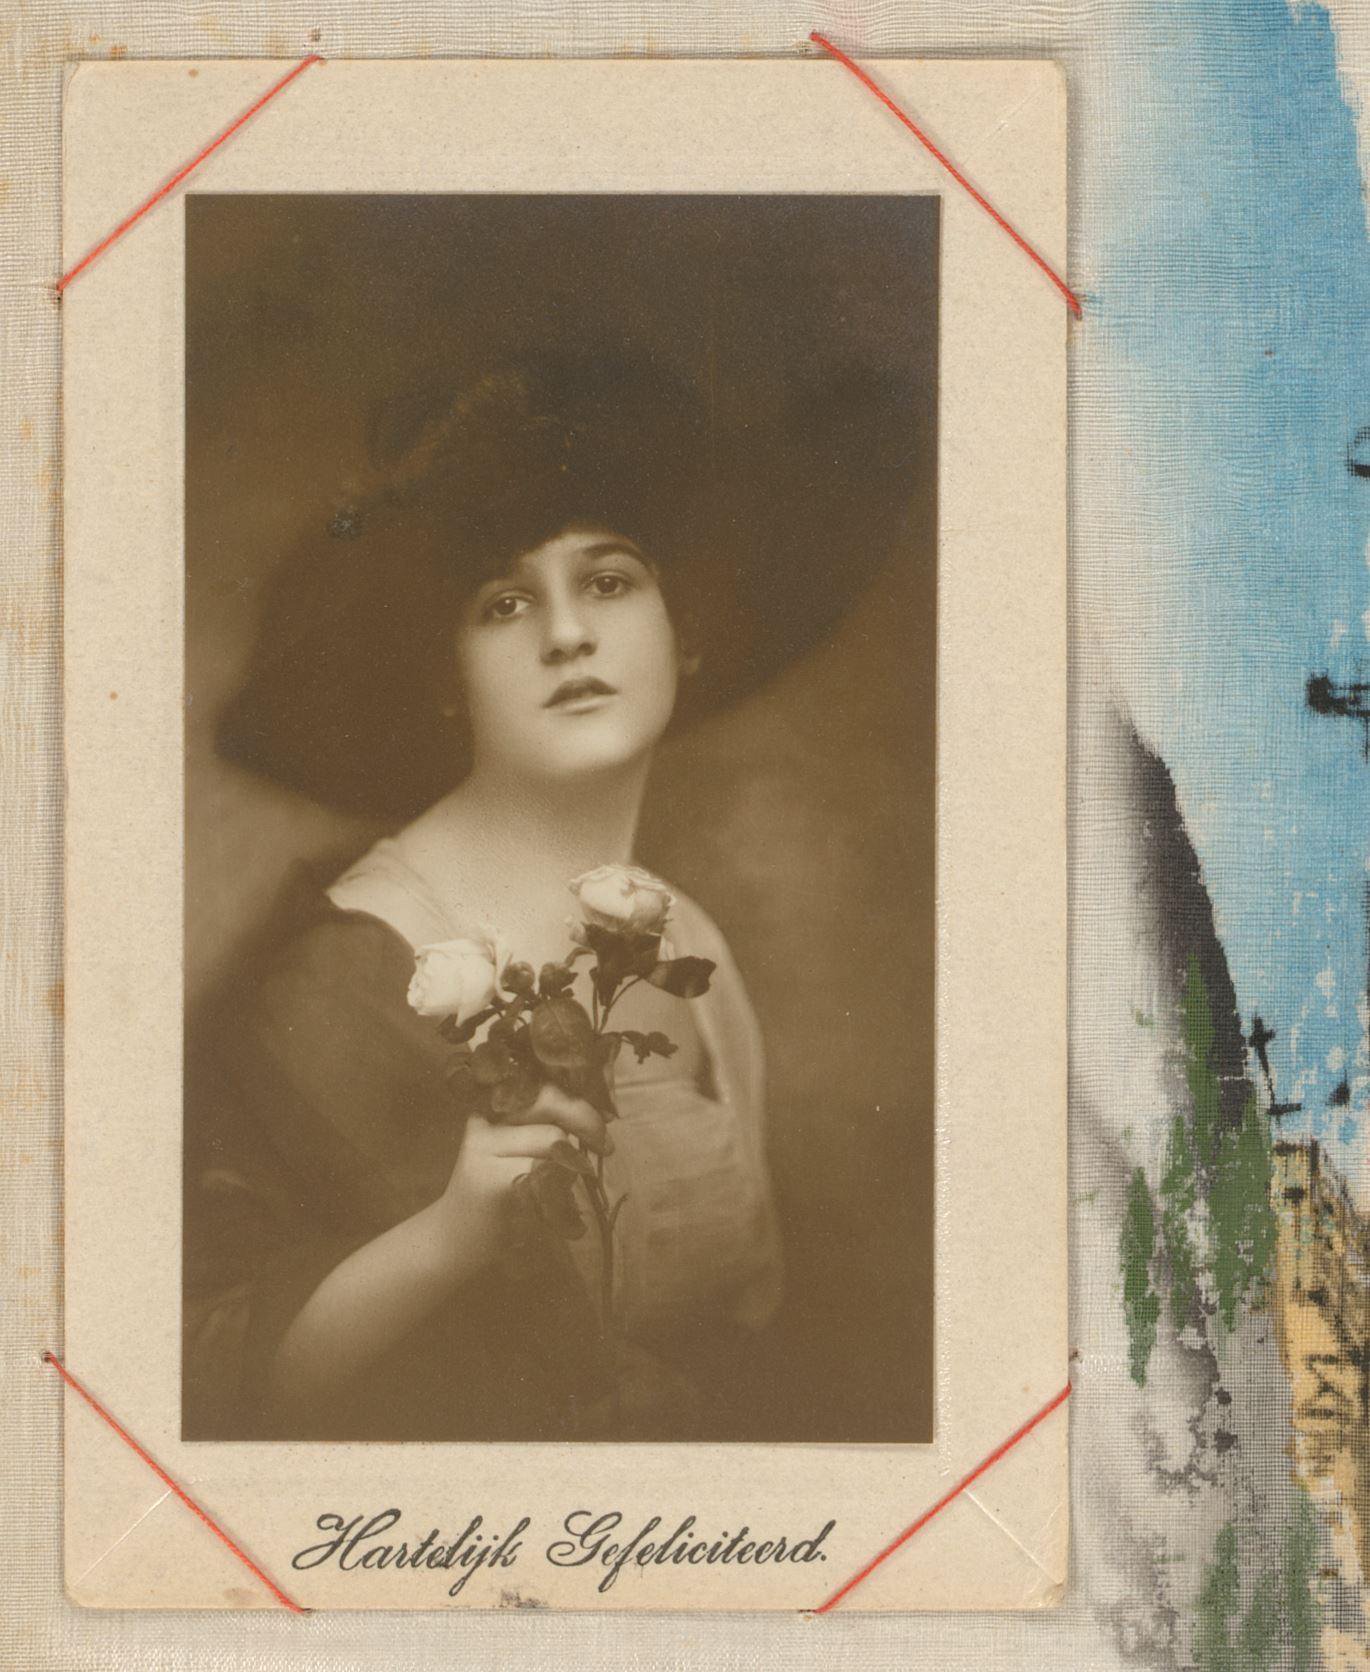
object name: photograph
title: Hartelijk Gefeliciteerd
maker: Anonymous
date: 1880-1920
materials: paint, photographic support, silk, textile, watercolor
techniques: brush, gelatin silver print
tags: flowers, adult woman, historical persons